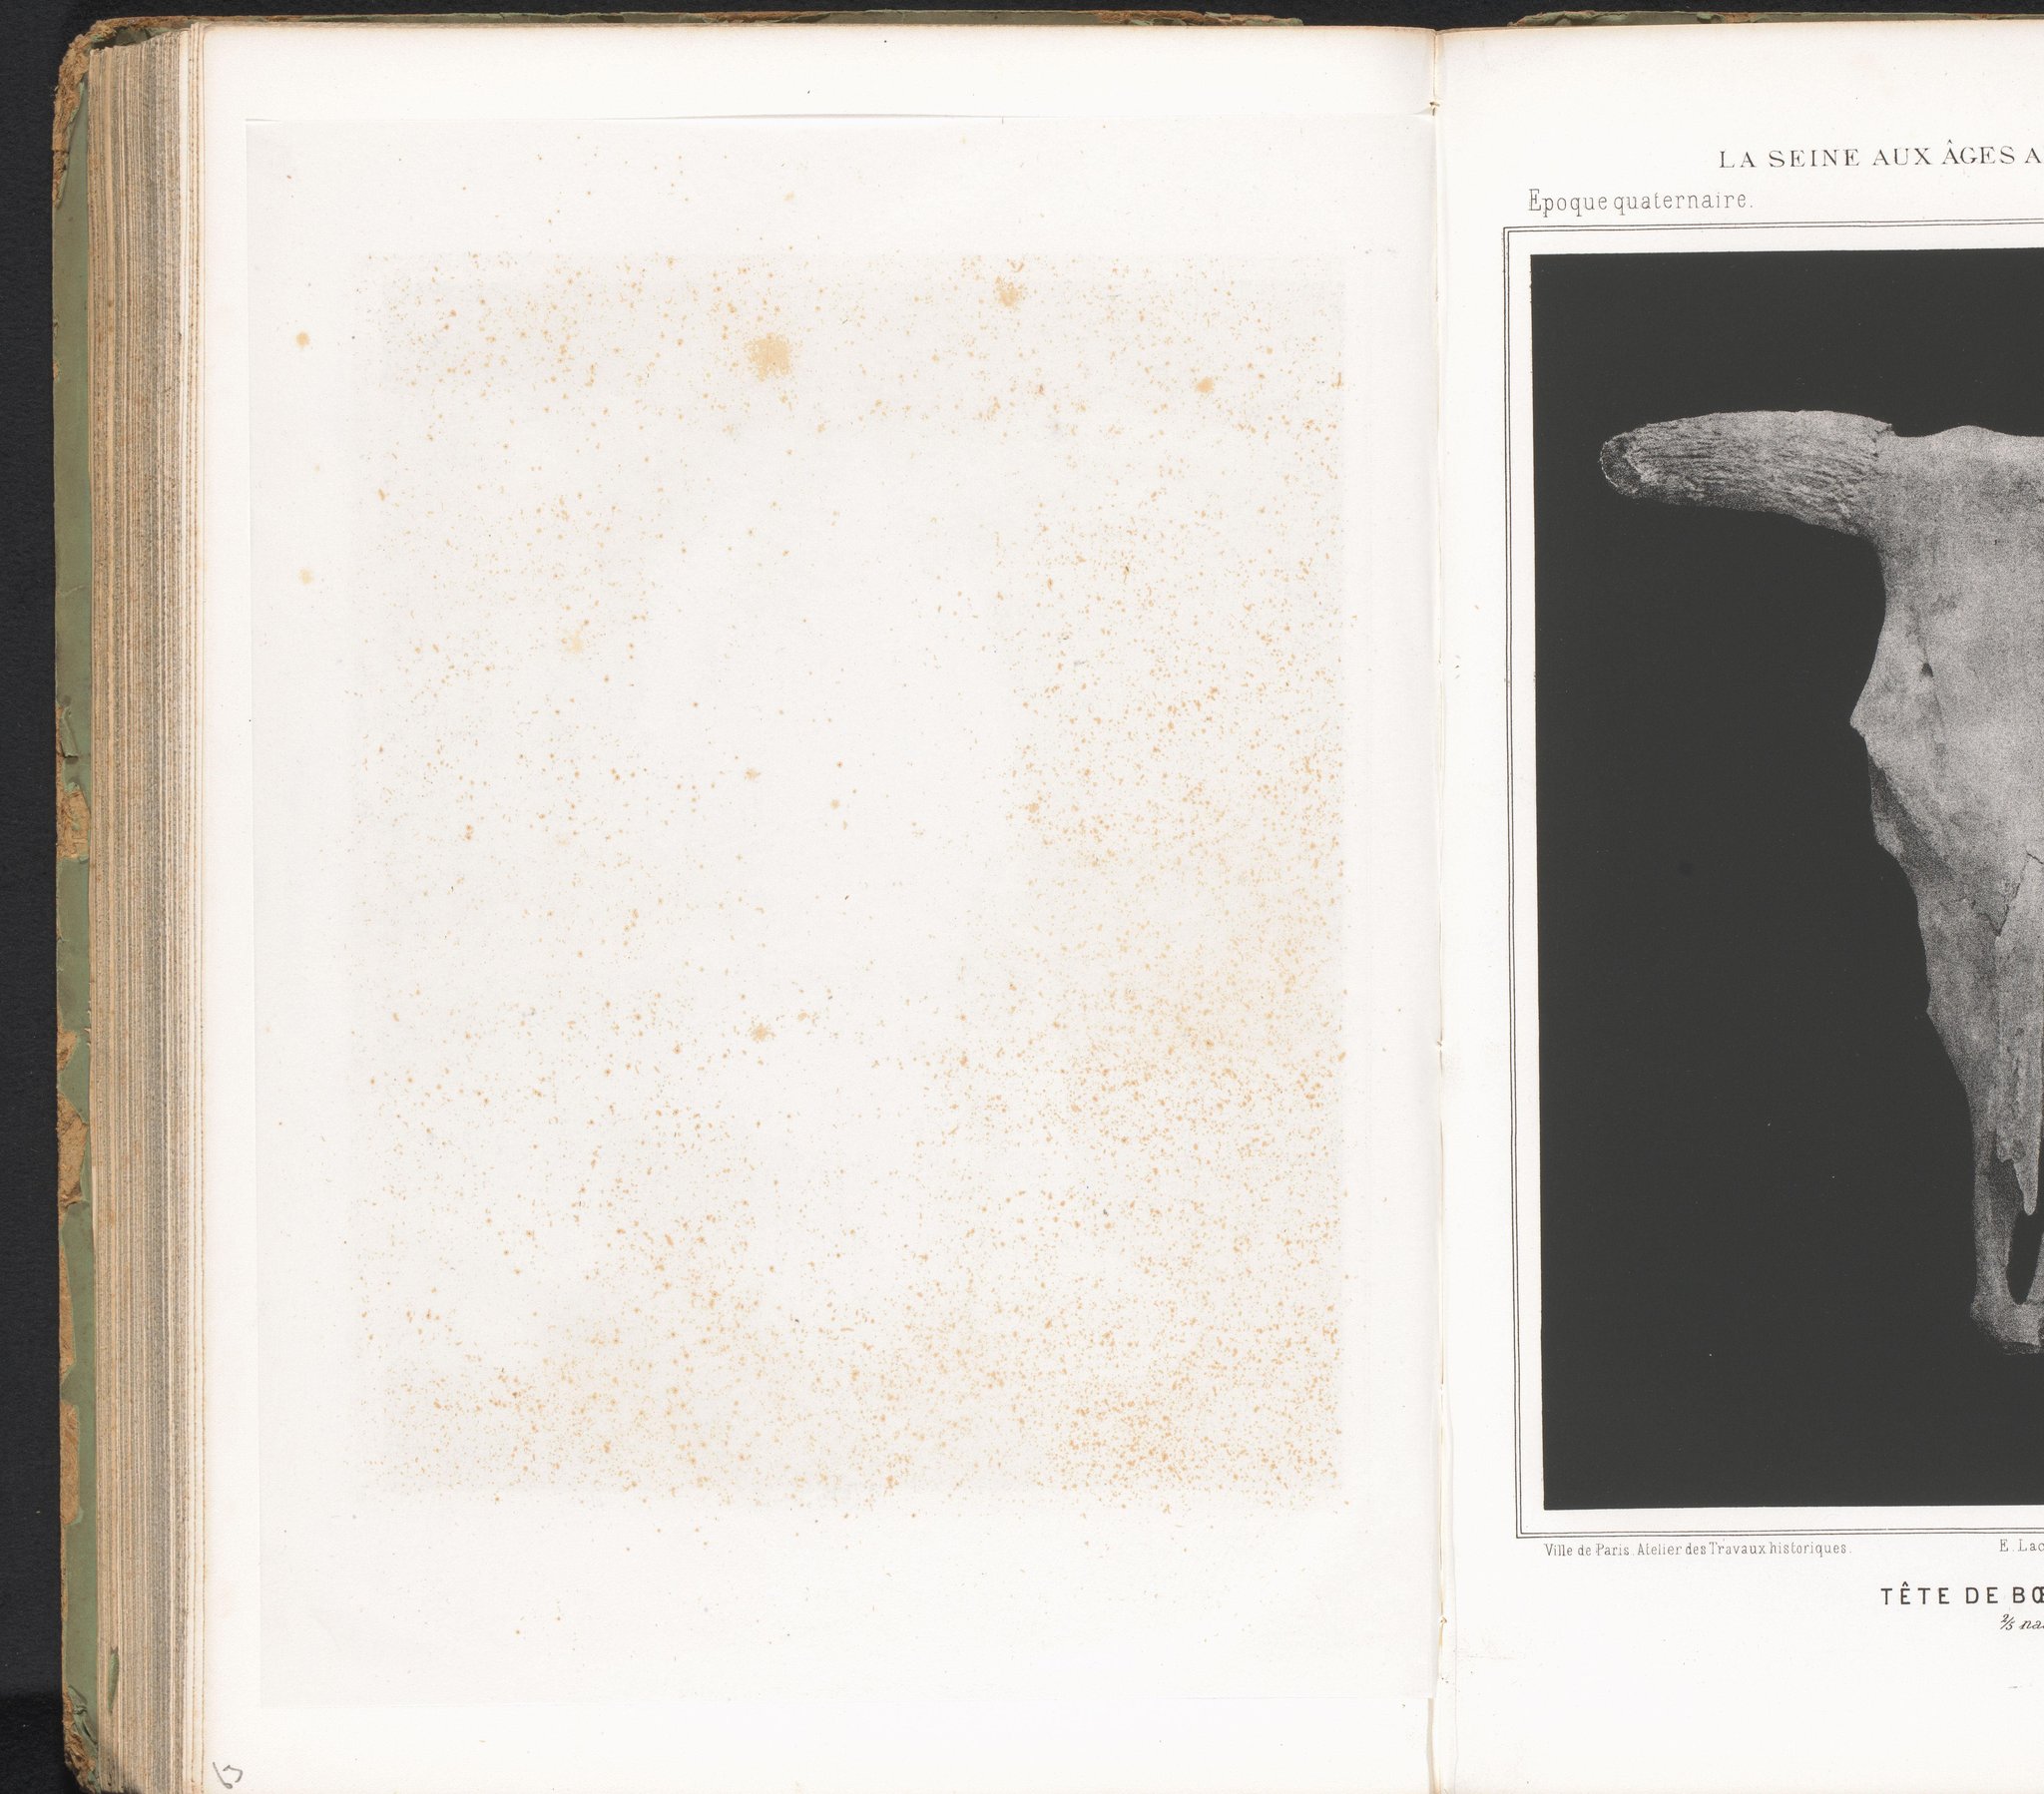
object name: page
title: Schedel van een rund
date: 1864-1869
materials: paper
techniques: photolithography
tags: mammals (+ skeleton of an animal)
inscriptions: inscription: ‘Procédé spécial photo-lithographique’, inscription: ‘2/5 nature’, inscription: ‘PL. 59 fer’, monogram: ‘EL’